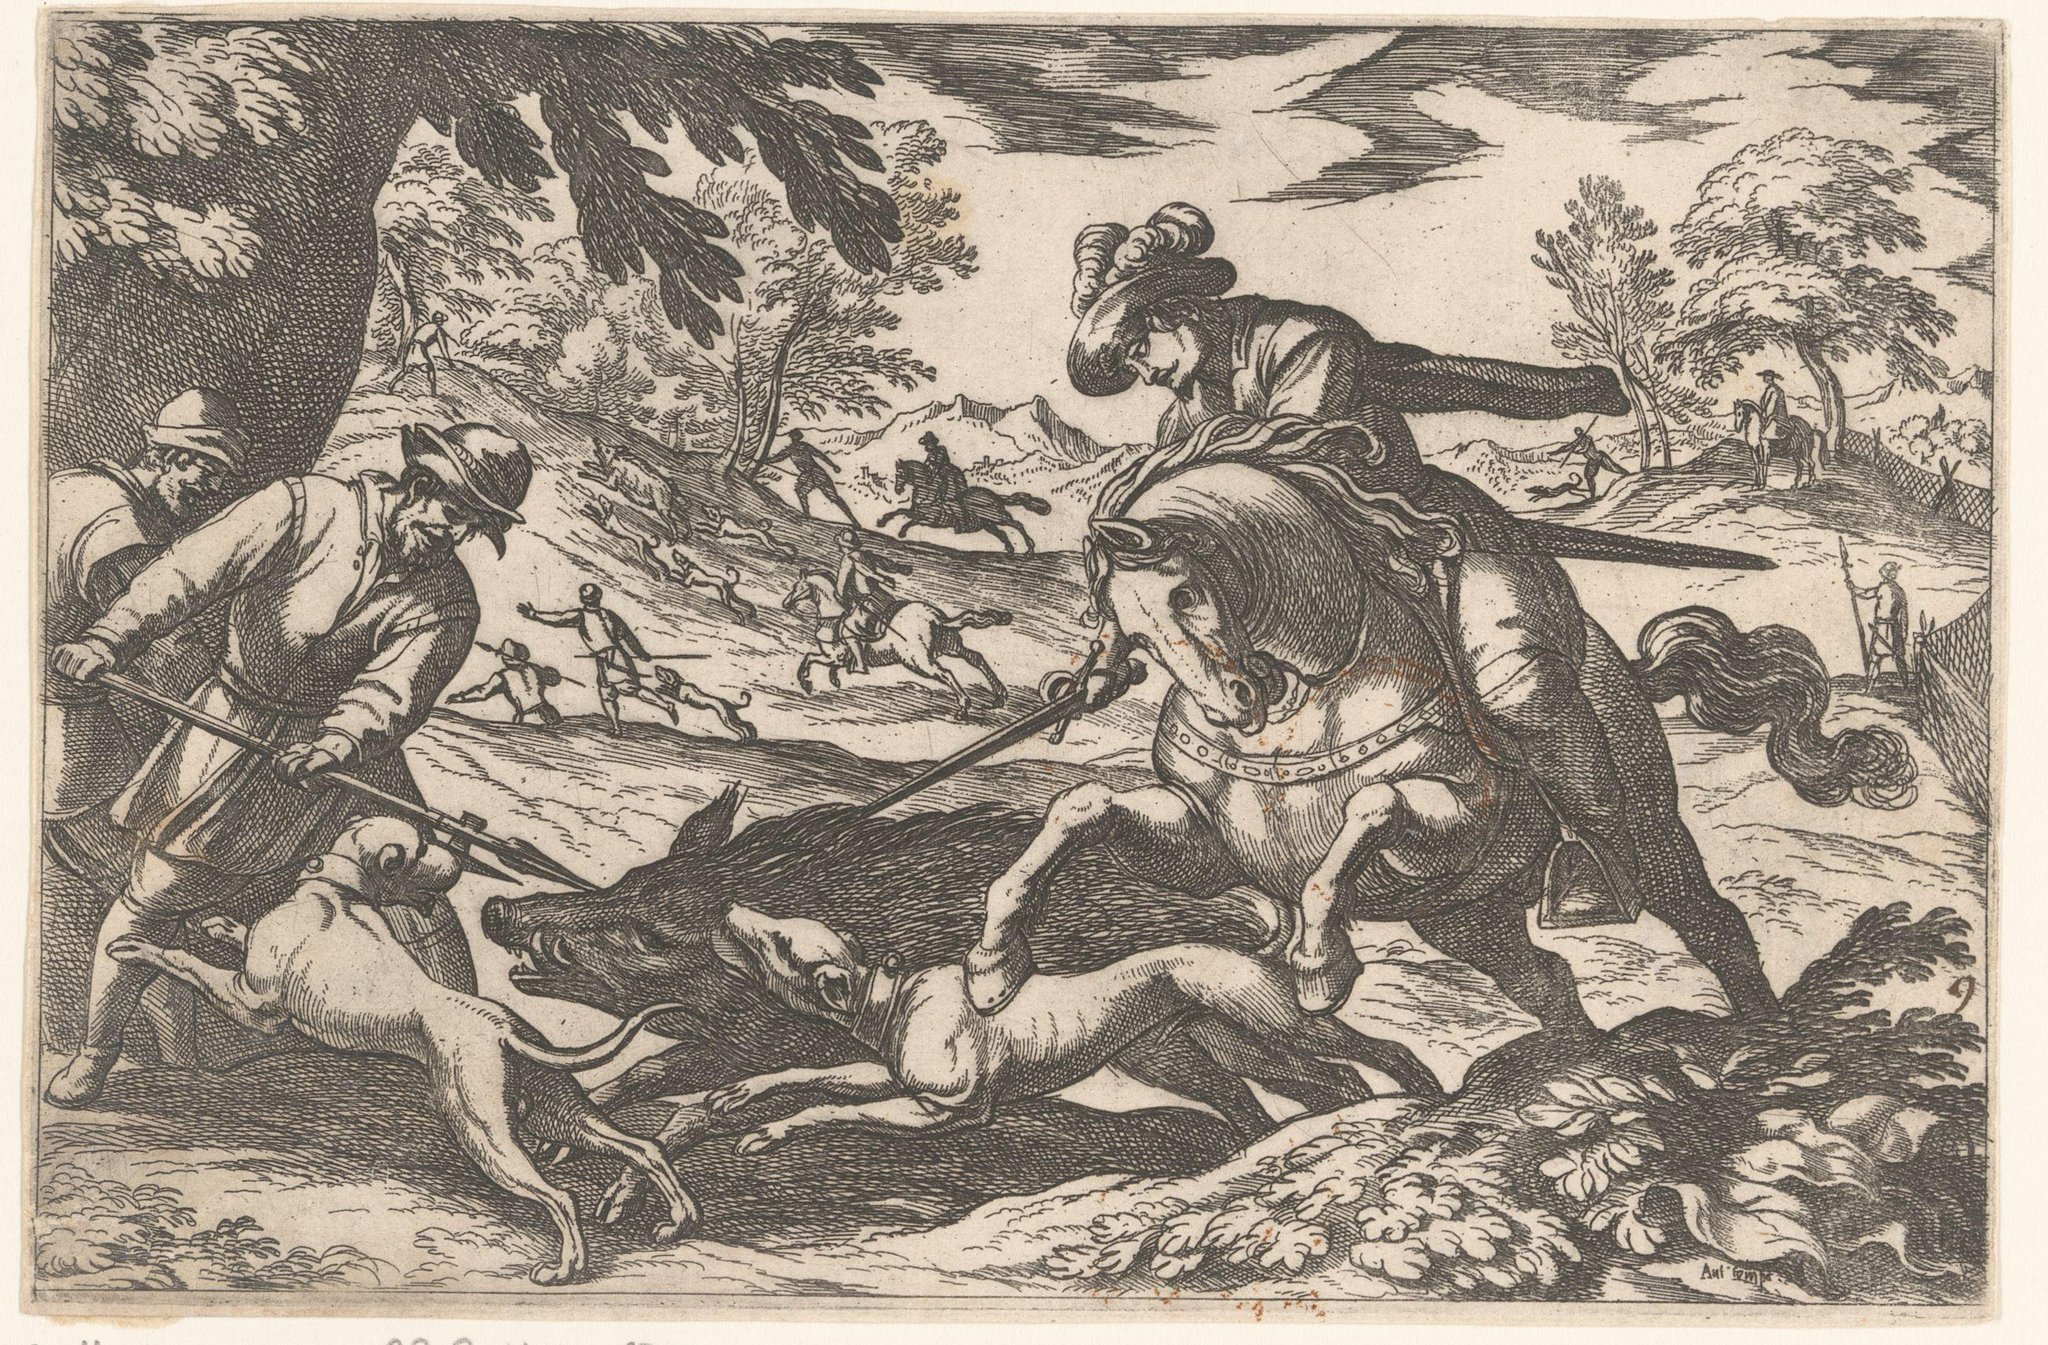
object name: print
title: Jachtscènes (deel 4)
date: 1595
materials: paper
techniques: etching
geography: italy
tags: boar-hunting, hunter, hunters hunting (n.b.: in 1988-1990 this notation denoted the concept of 43c11421 'hunters resting during the hunt')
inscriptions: collector's mark: ‘Hinloopen’, collector's mark: Lugt 11, number: ‘7’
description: Deze prent maakt deel uit van een reeks van elf prenten met jachtscènes (+ opdracht).